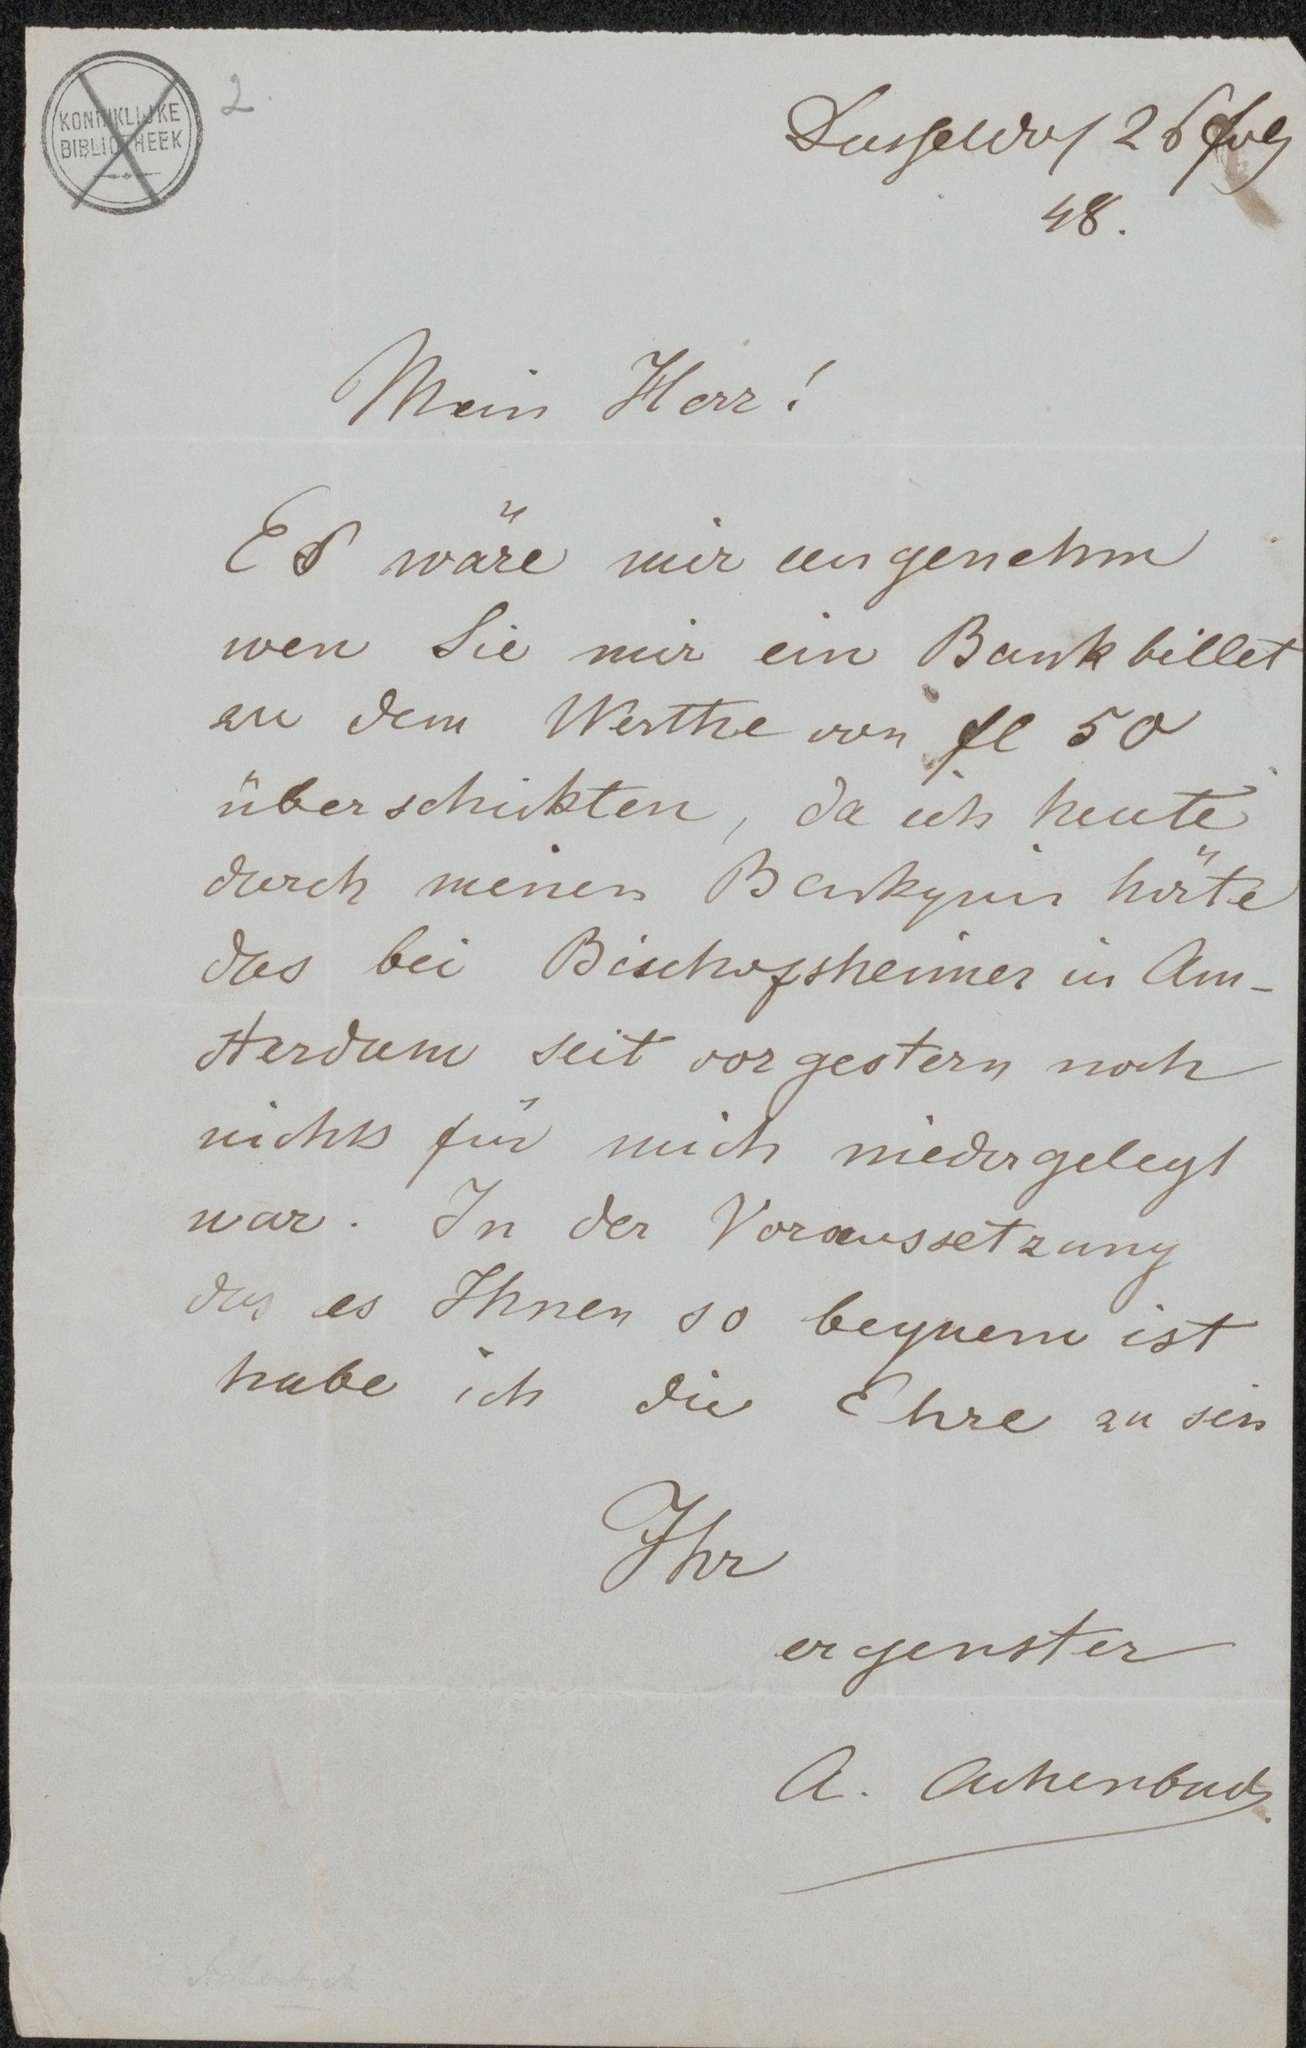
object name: letter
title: Brief aan C.J. de Lang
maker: andreas achenbach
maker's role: print maker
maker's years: 1815-1910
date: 1848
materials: ink, paper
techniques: pen, writing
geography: dusseldorf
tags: money, amsterdam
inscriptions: collector's mark: ‘KONINKLIJKE BIBLIOTHEEK’, collector's mark: Lugt 2233